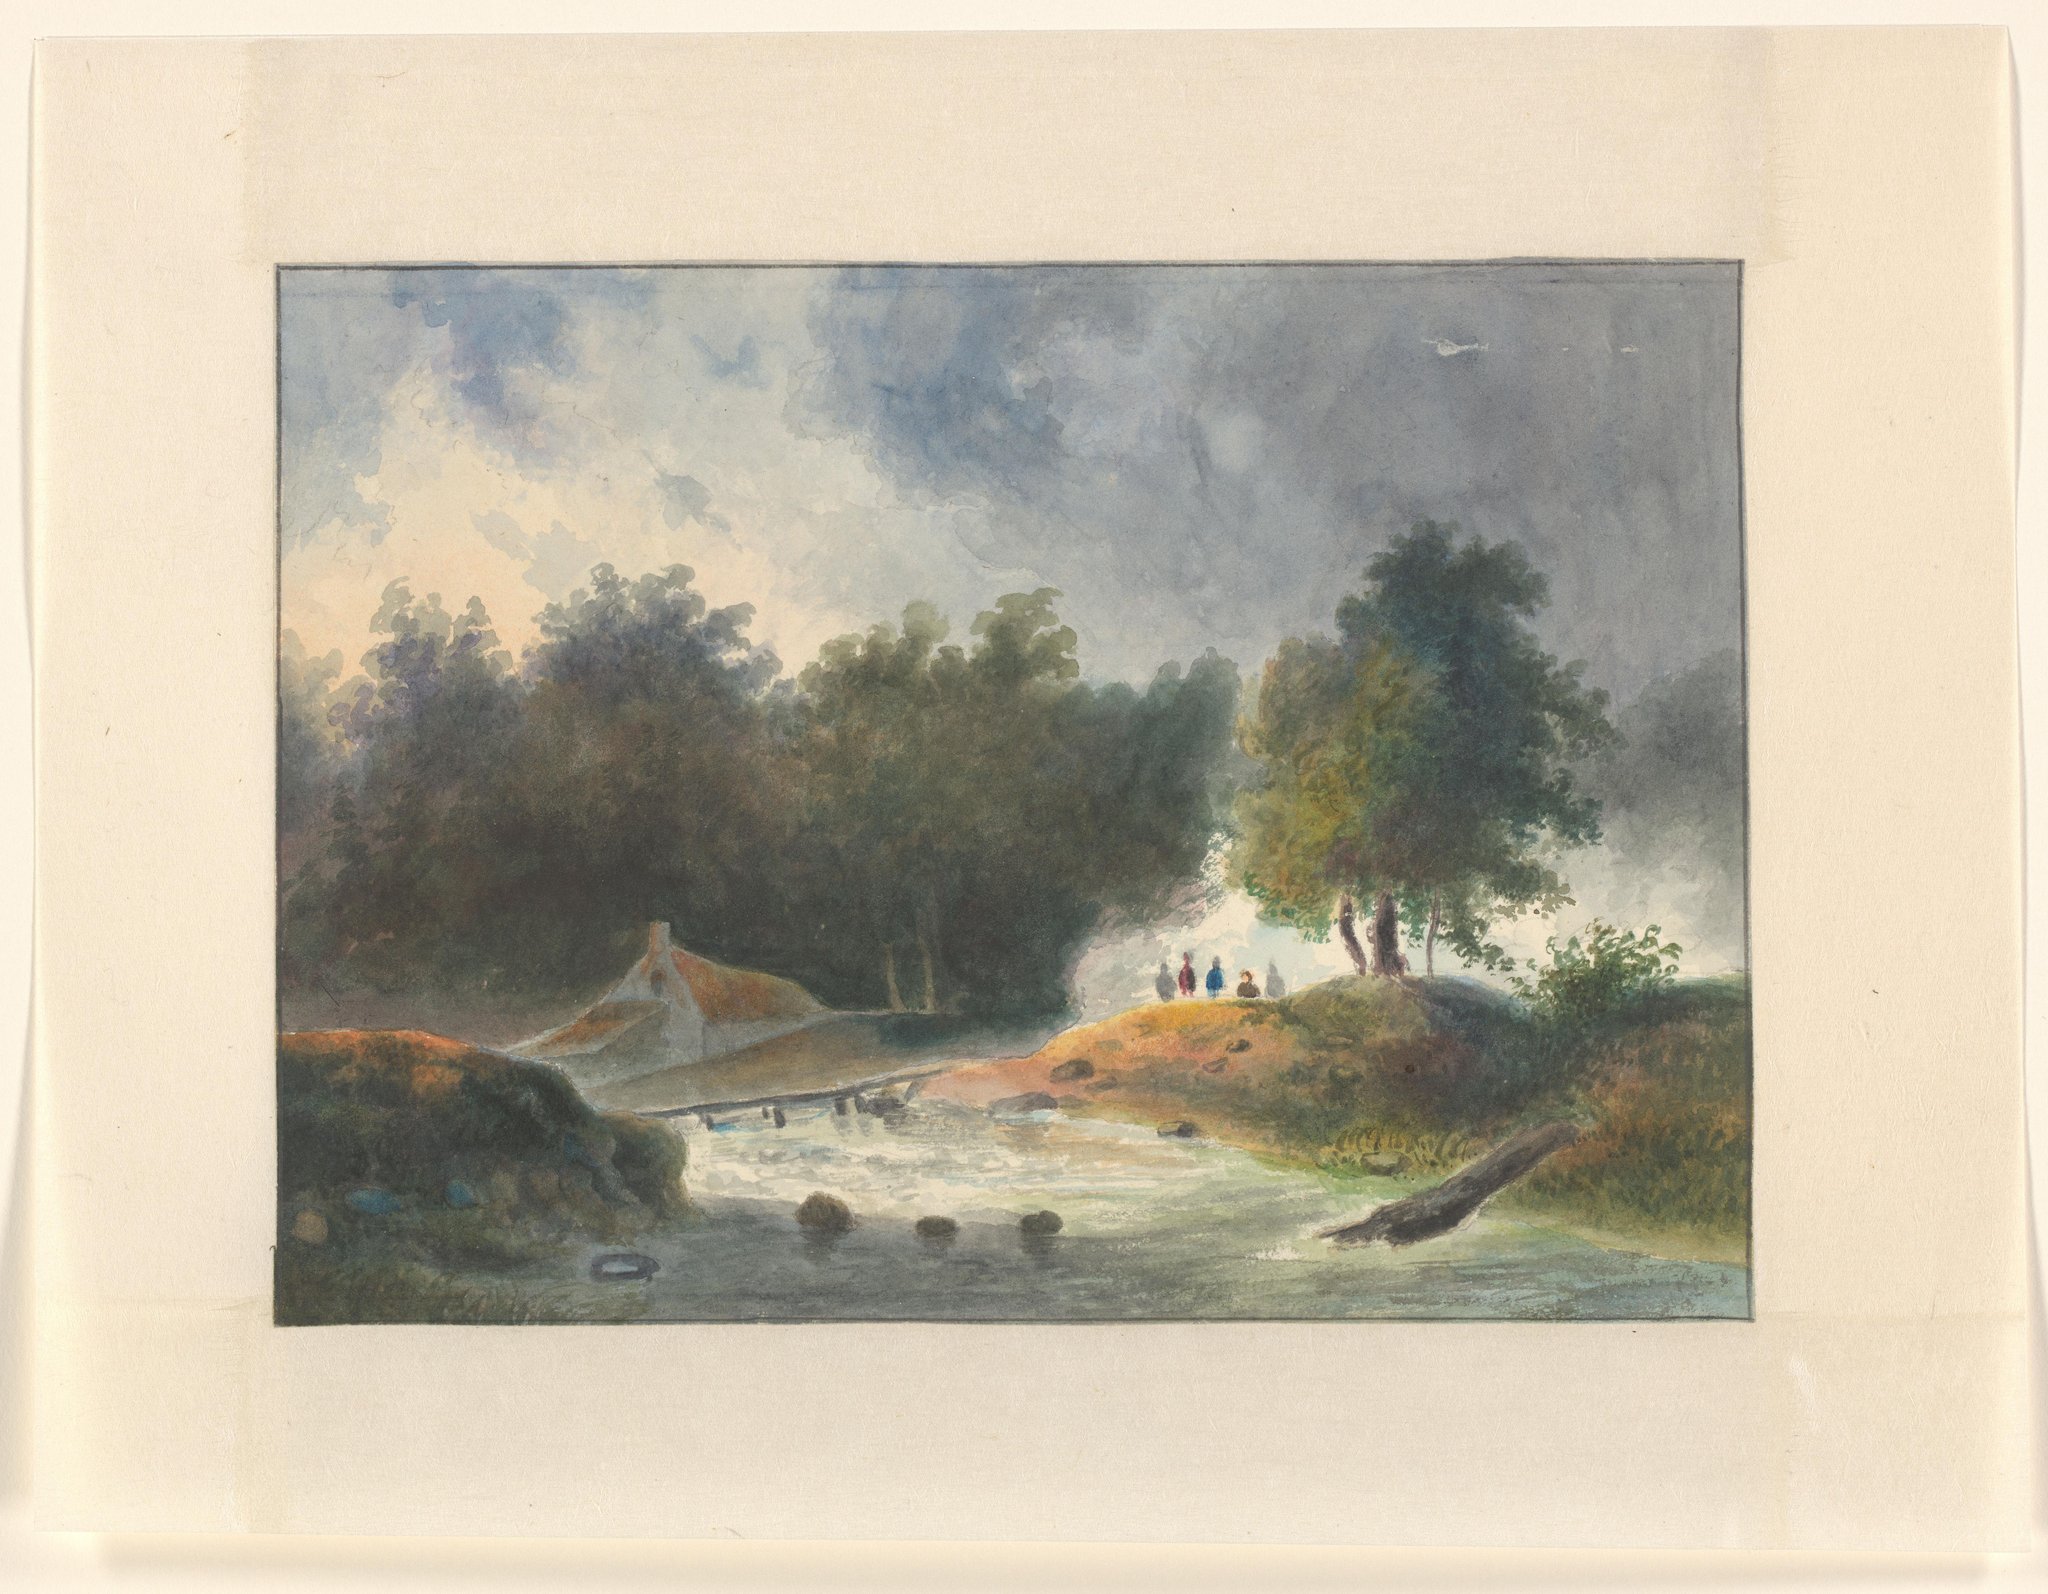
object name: drawing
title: Figuren bij een brug over een rivier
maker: johannes van reijn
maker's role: draughtsman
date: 1800-1900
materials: paper, pencil, watercolor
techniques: brush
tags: river, forest, wood